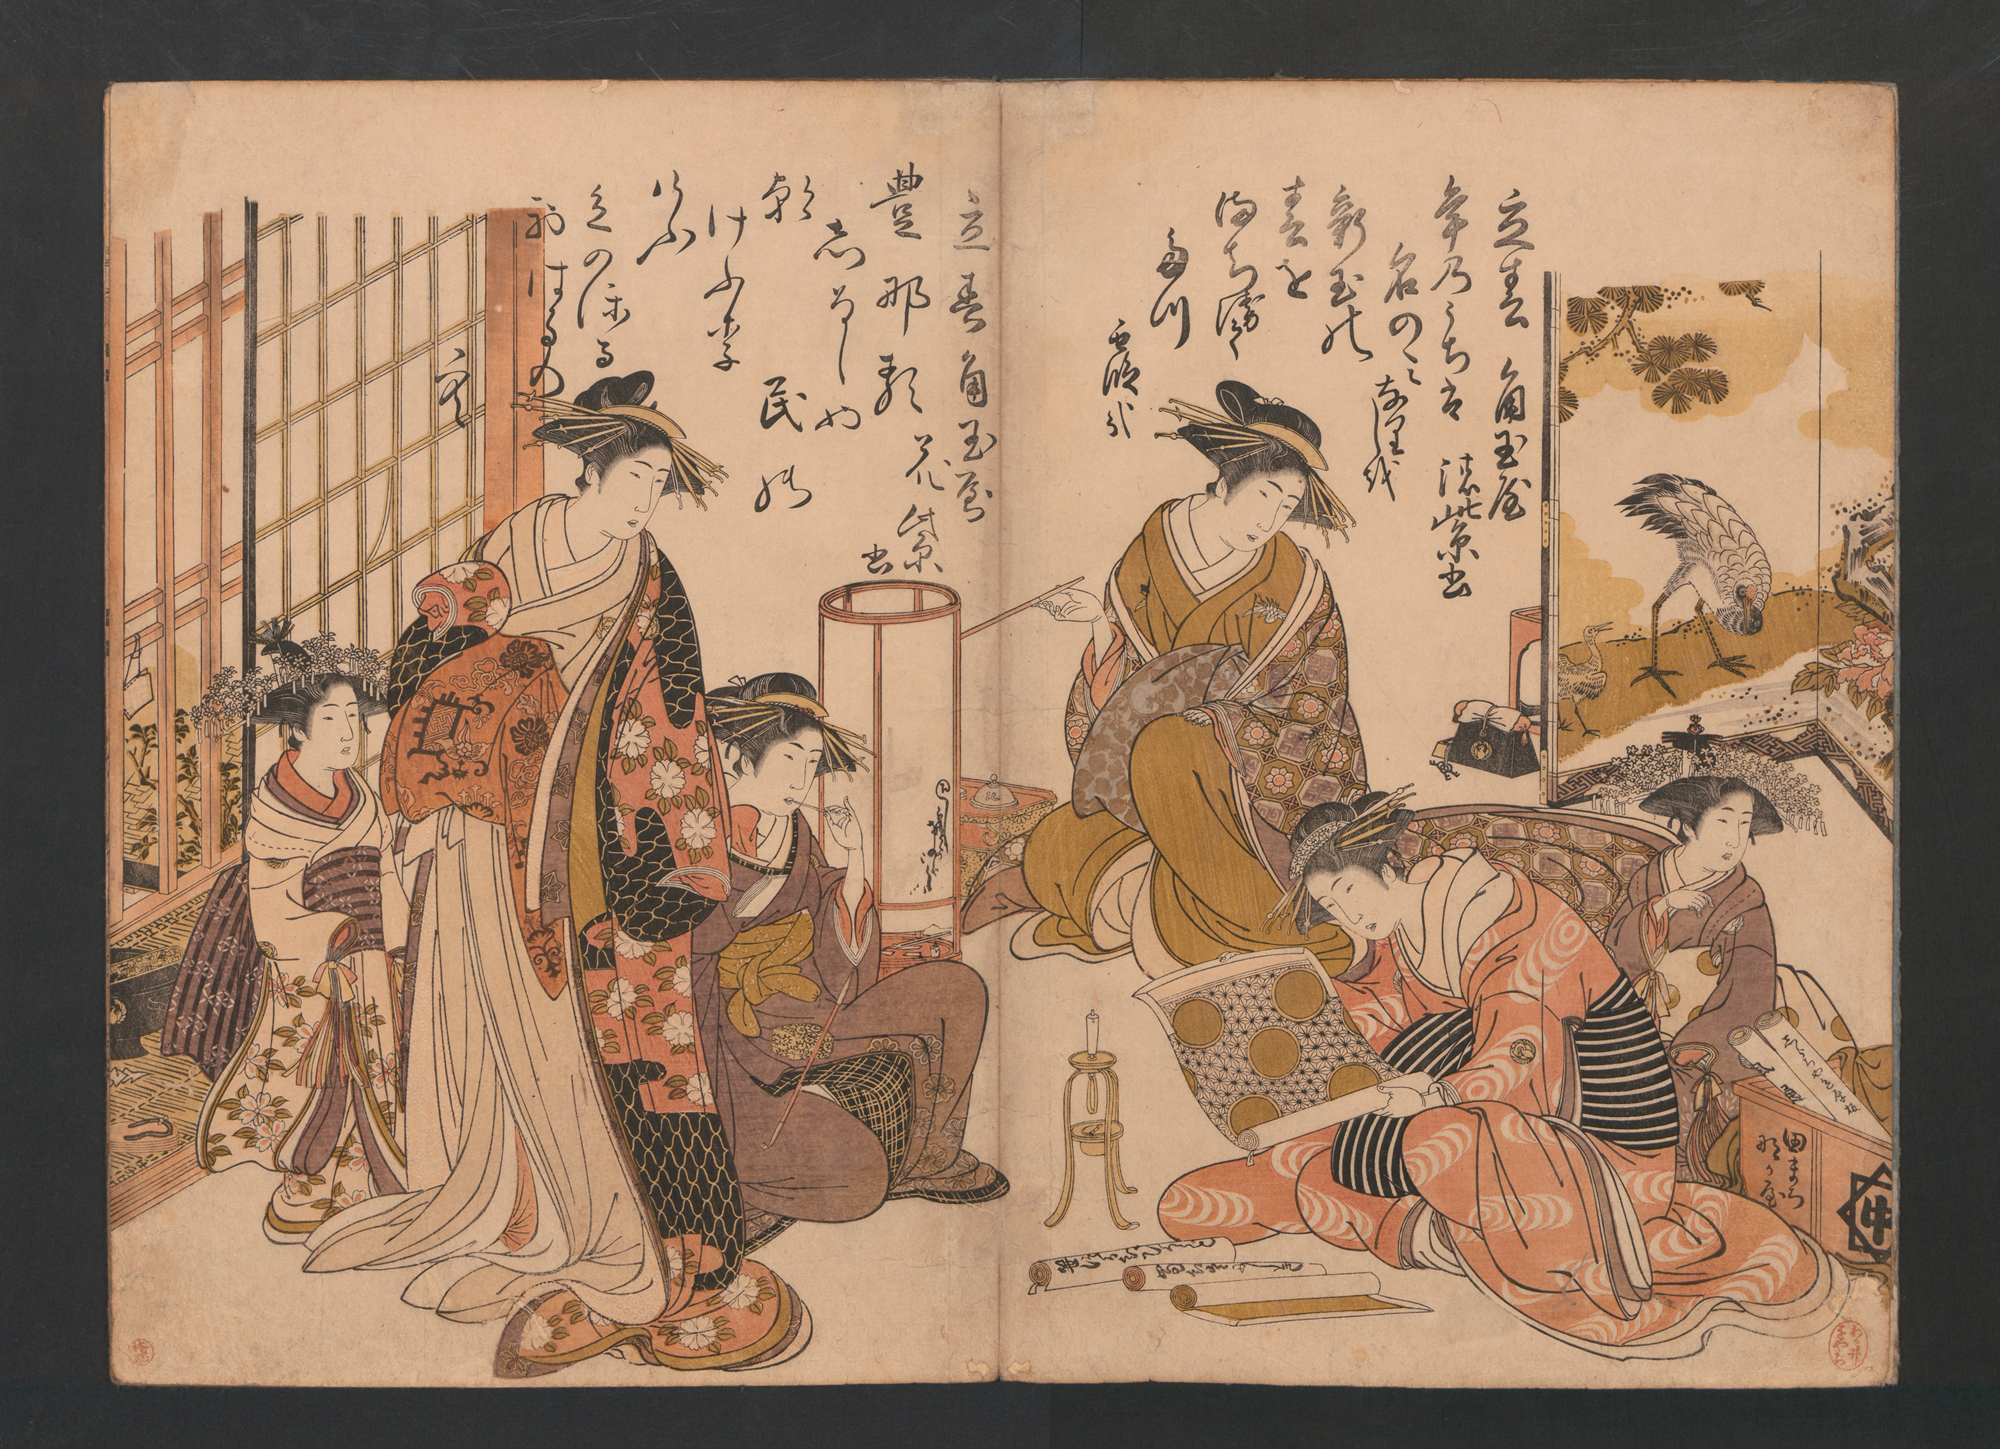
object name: illustrated book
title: Yoshiwara Courtesans: A New Mirror Comparing the Calligraphy of Beauties (Yoshiwara keisei: Shin bijin awase jihitsu kagami)吉原傾城」新美人合自筆鏡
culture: japanese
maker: kitao masanobu (santō kyōden) 北尾政演 (山東京伝)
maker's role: artist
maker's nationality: japanese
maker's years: 1761-1816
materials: ink, paper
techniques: polychrome, woodblock print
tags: birds,women